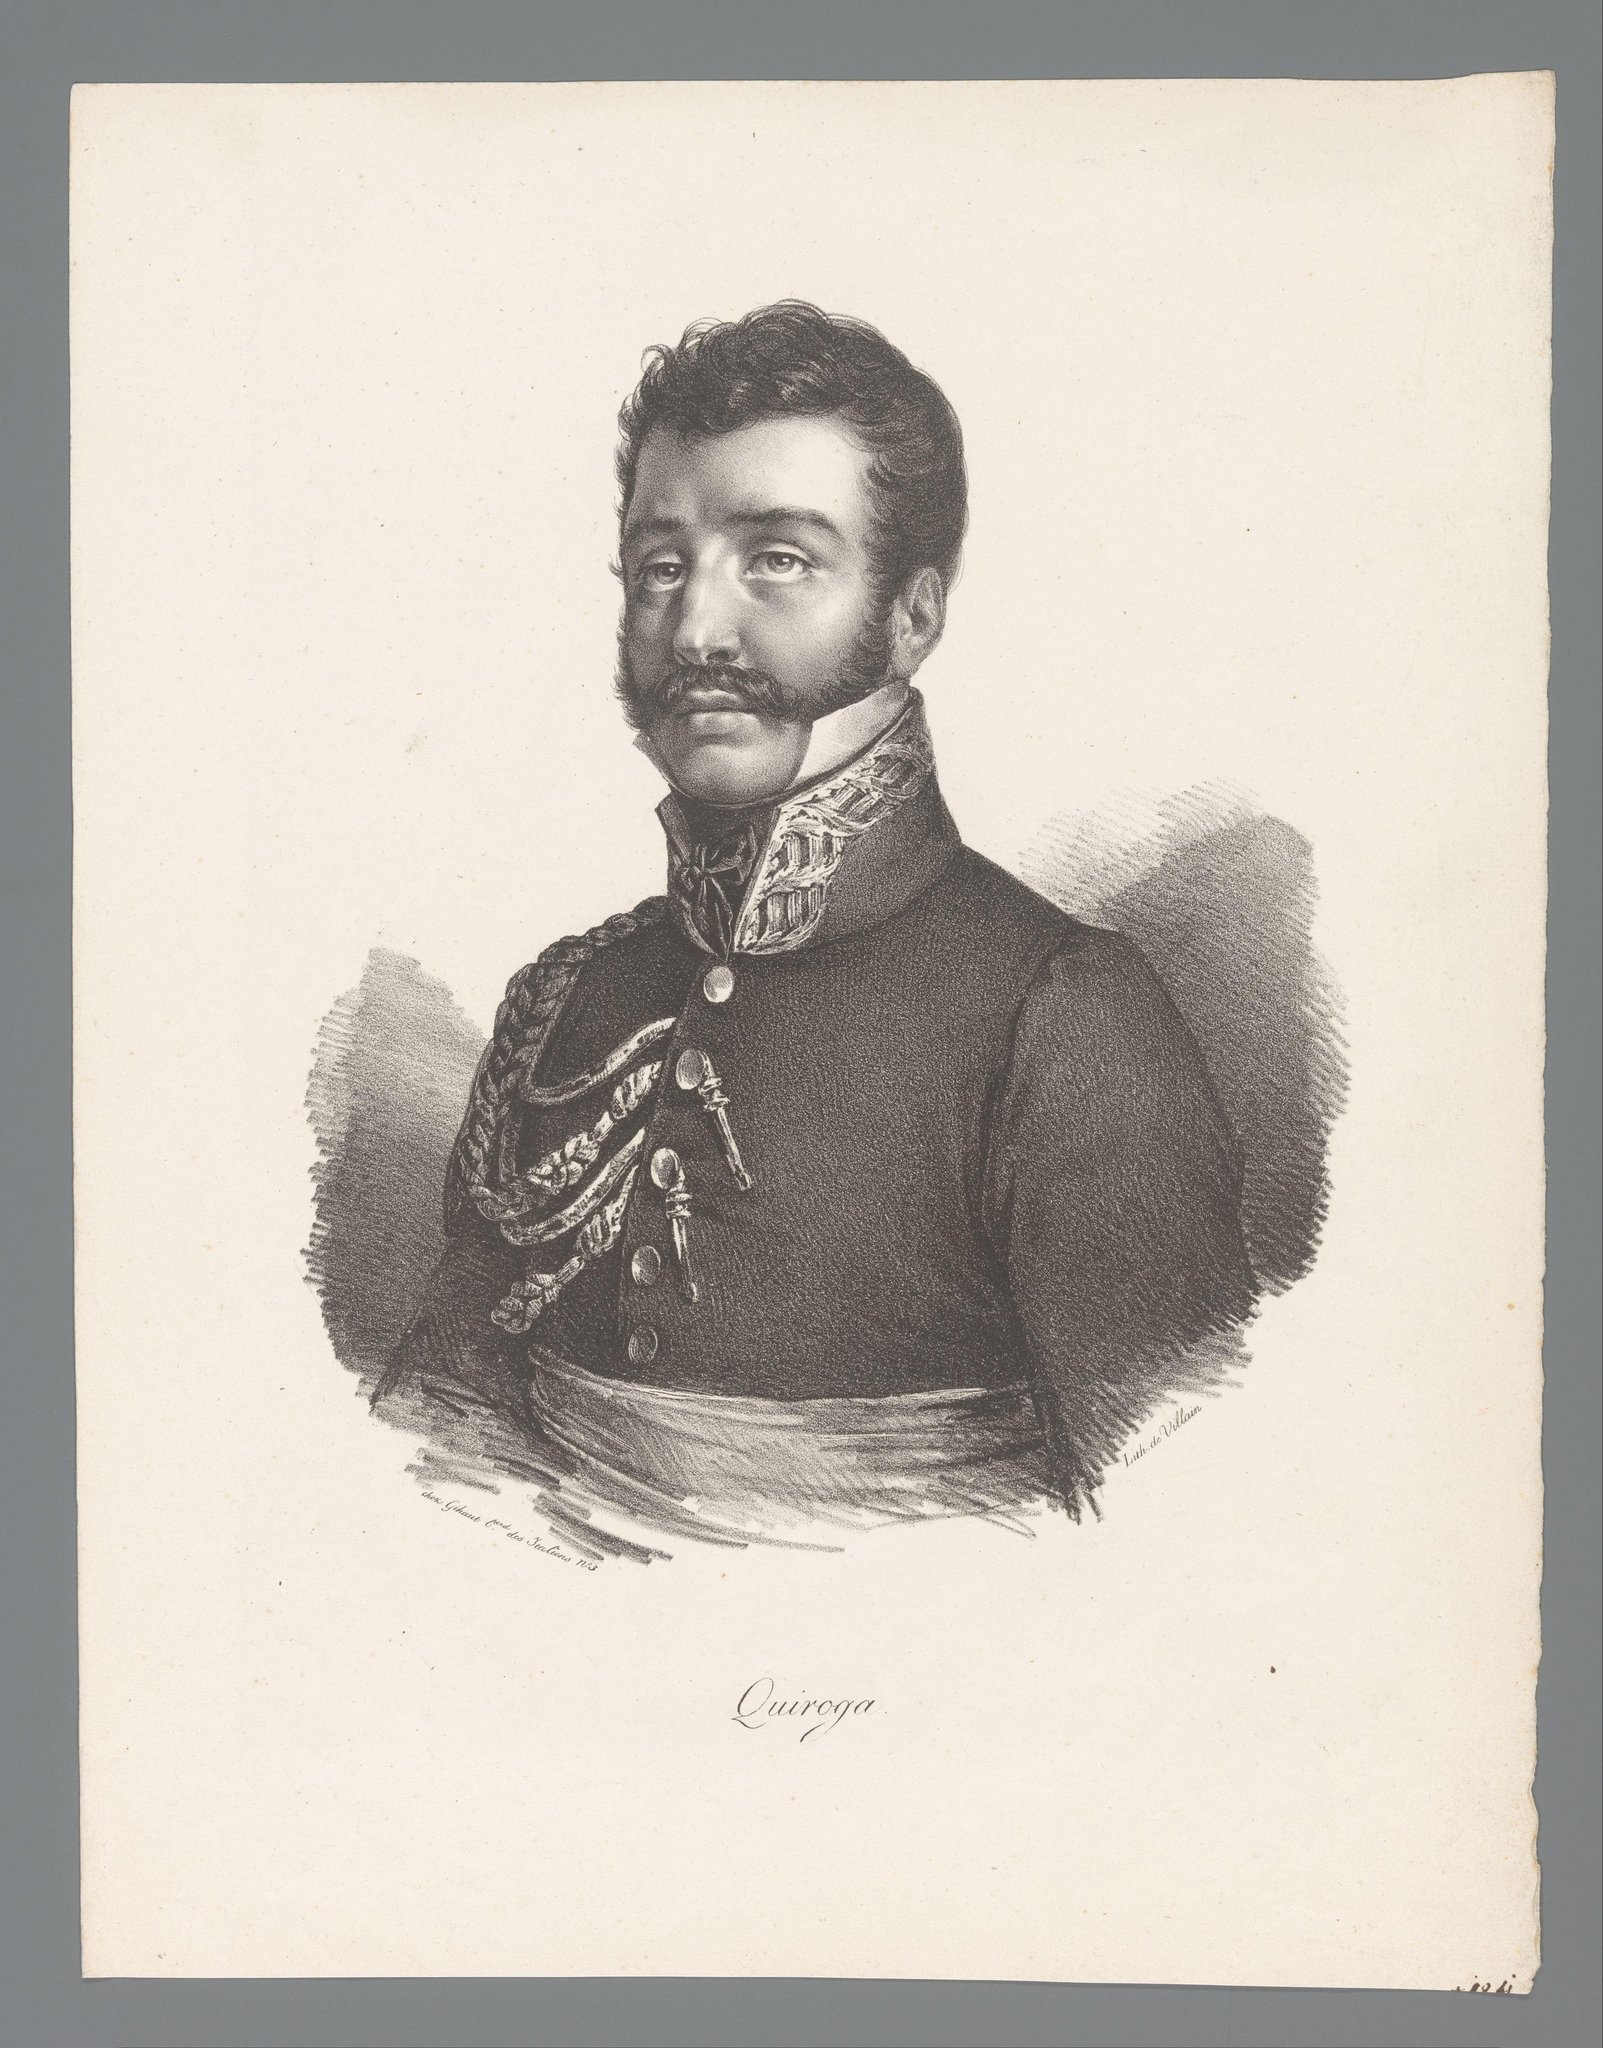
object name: print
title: Quiroga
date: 1823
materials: paper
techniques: lithograph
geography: paris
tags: spain, historical persons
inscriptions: collector's mark: Lugt 2228